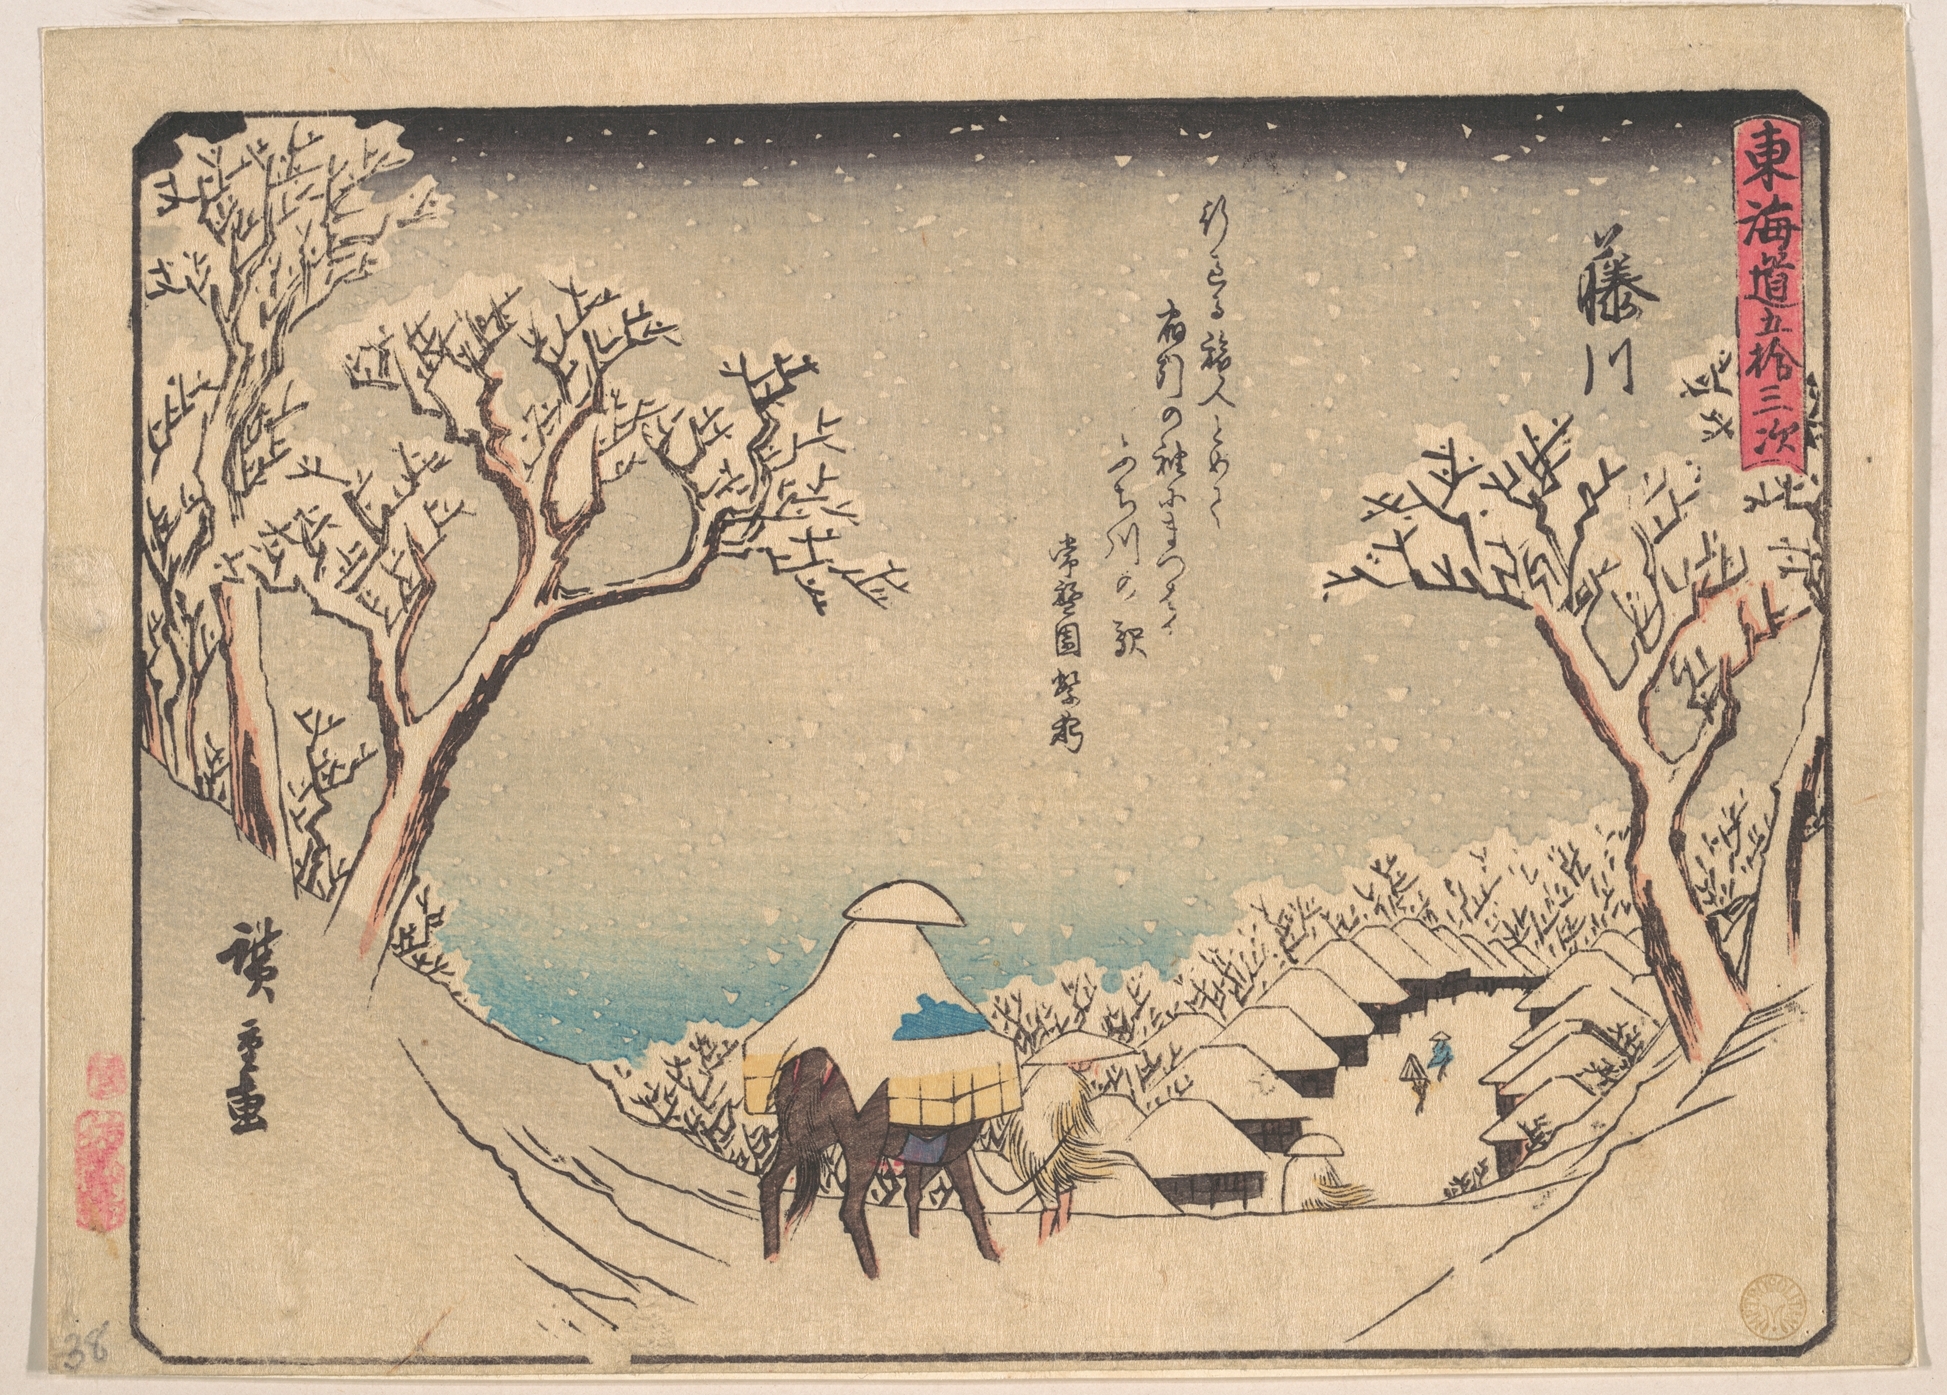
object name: print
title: Fujikawa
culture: japanese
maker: utagawa hiroshige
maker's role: artist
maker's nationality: japanese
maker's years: 1797-1858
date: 1838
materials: ink, paper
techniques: woodblock print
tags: human figures,animals,houses,trees,snow